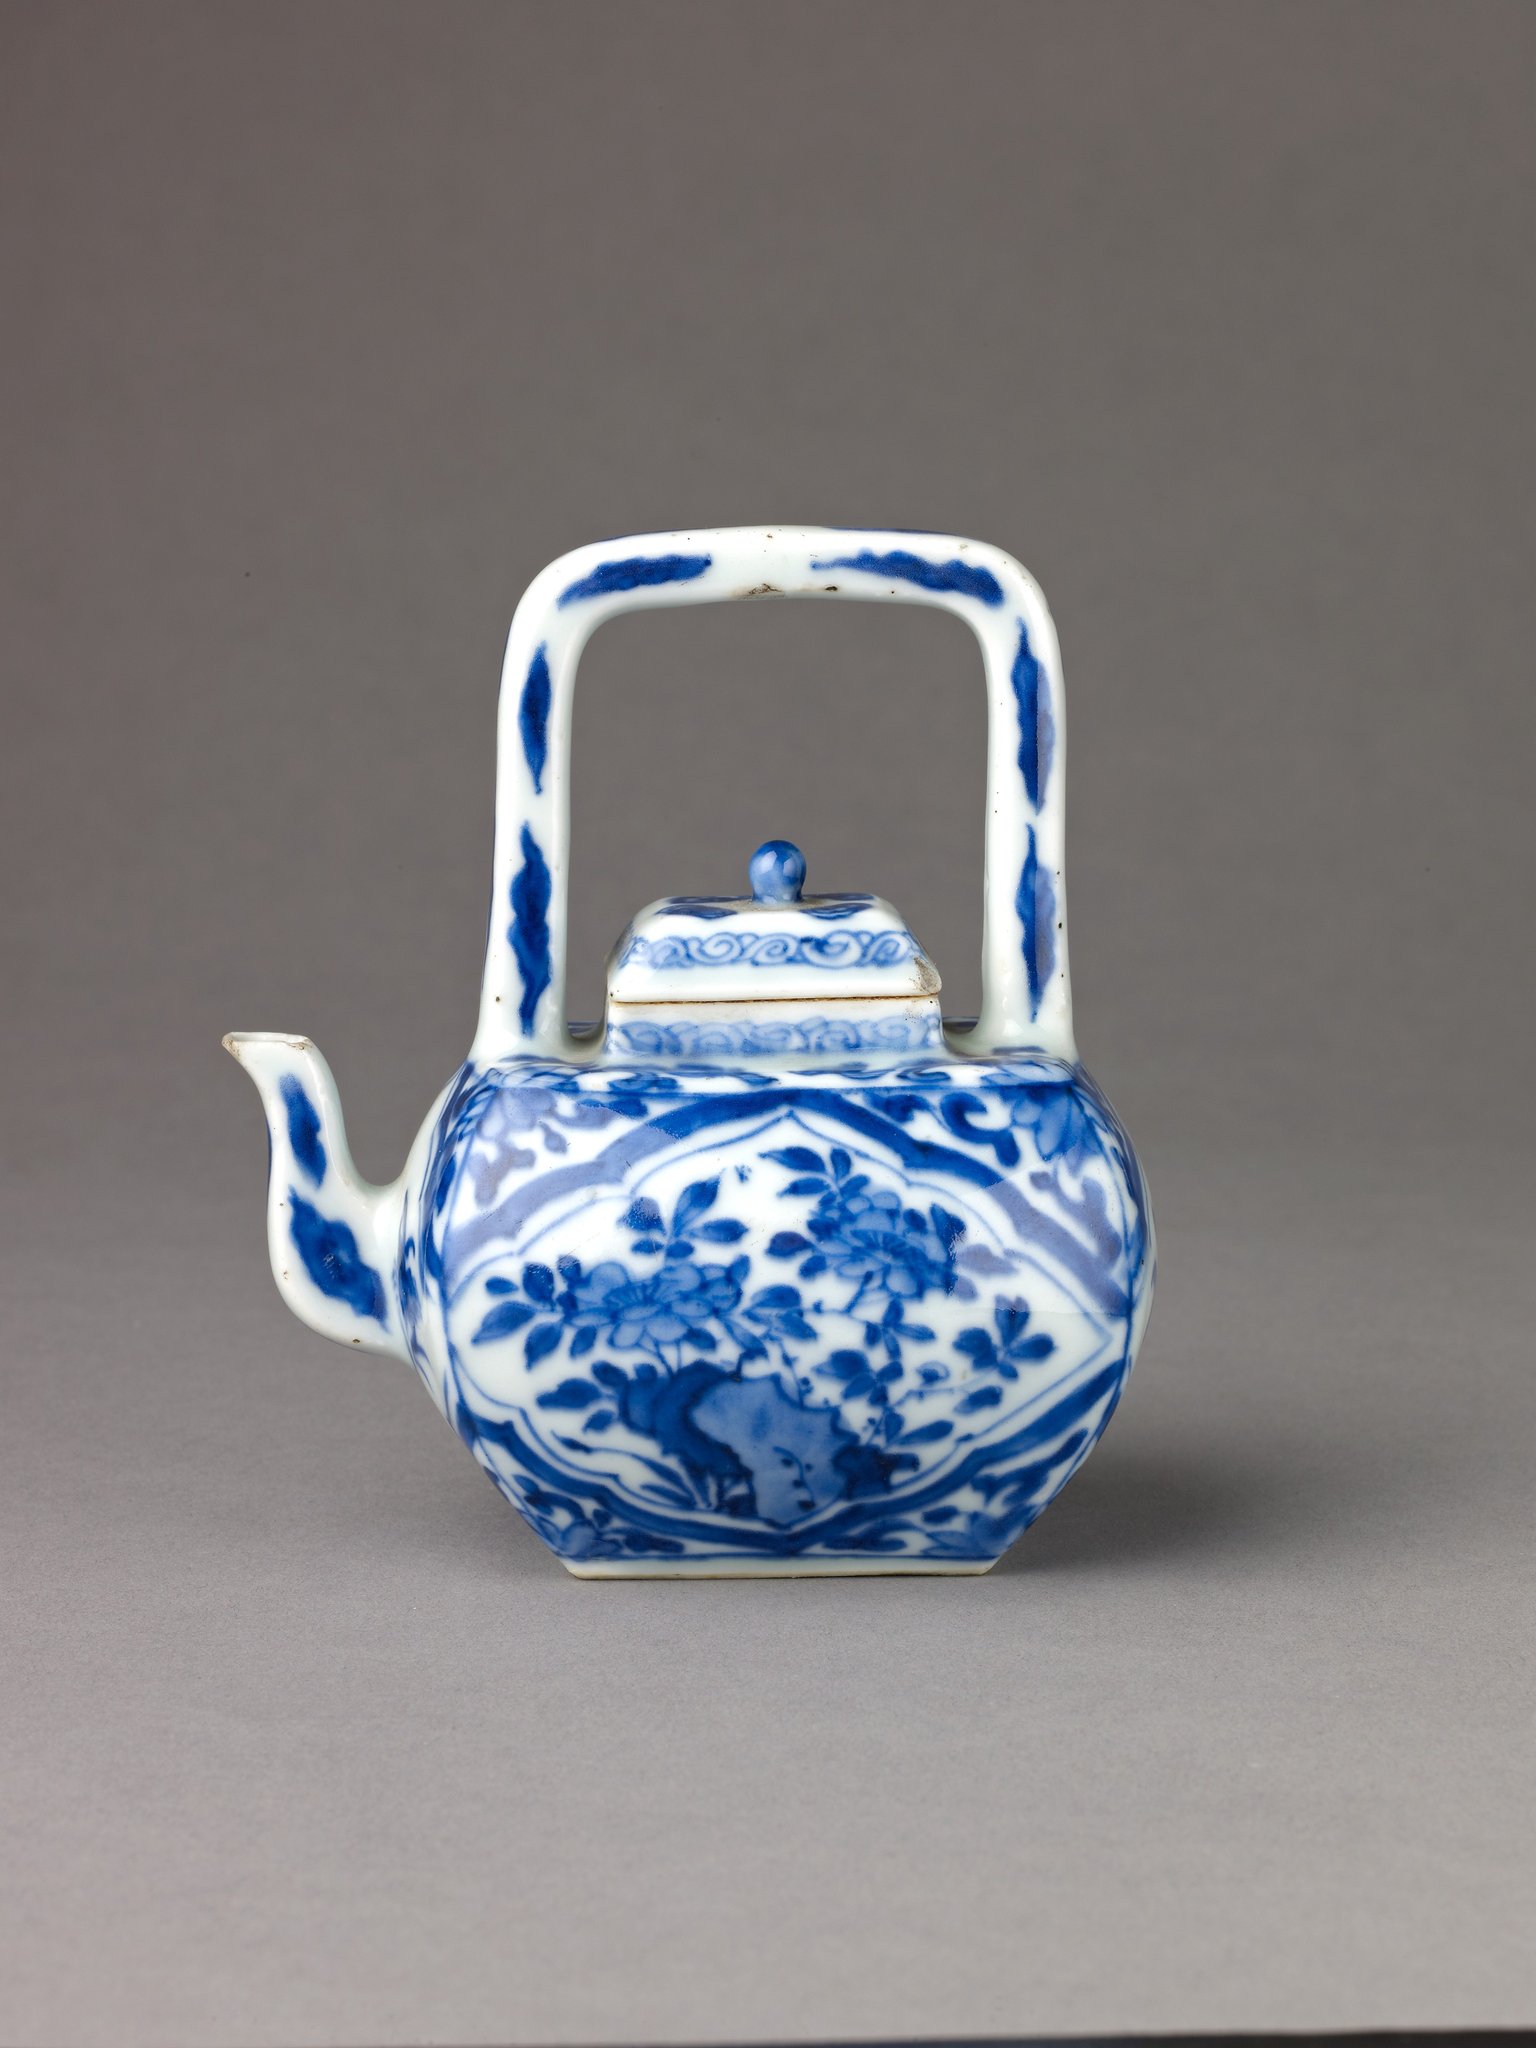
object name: covered winepot or teapot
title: Small covered wine pot or teapot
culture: chinese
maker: chinese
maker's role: artist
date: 1662-1722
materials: porcelain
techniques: painting, underglaze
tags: flowers